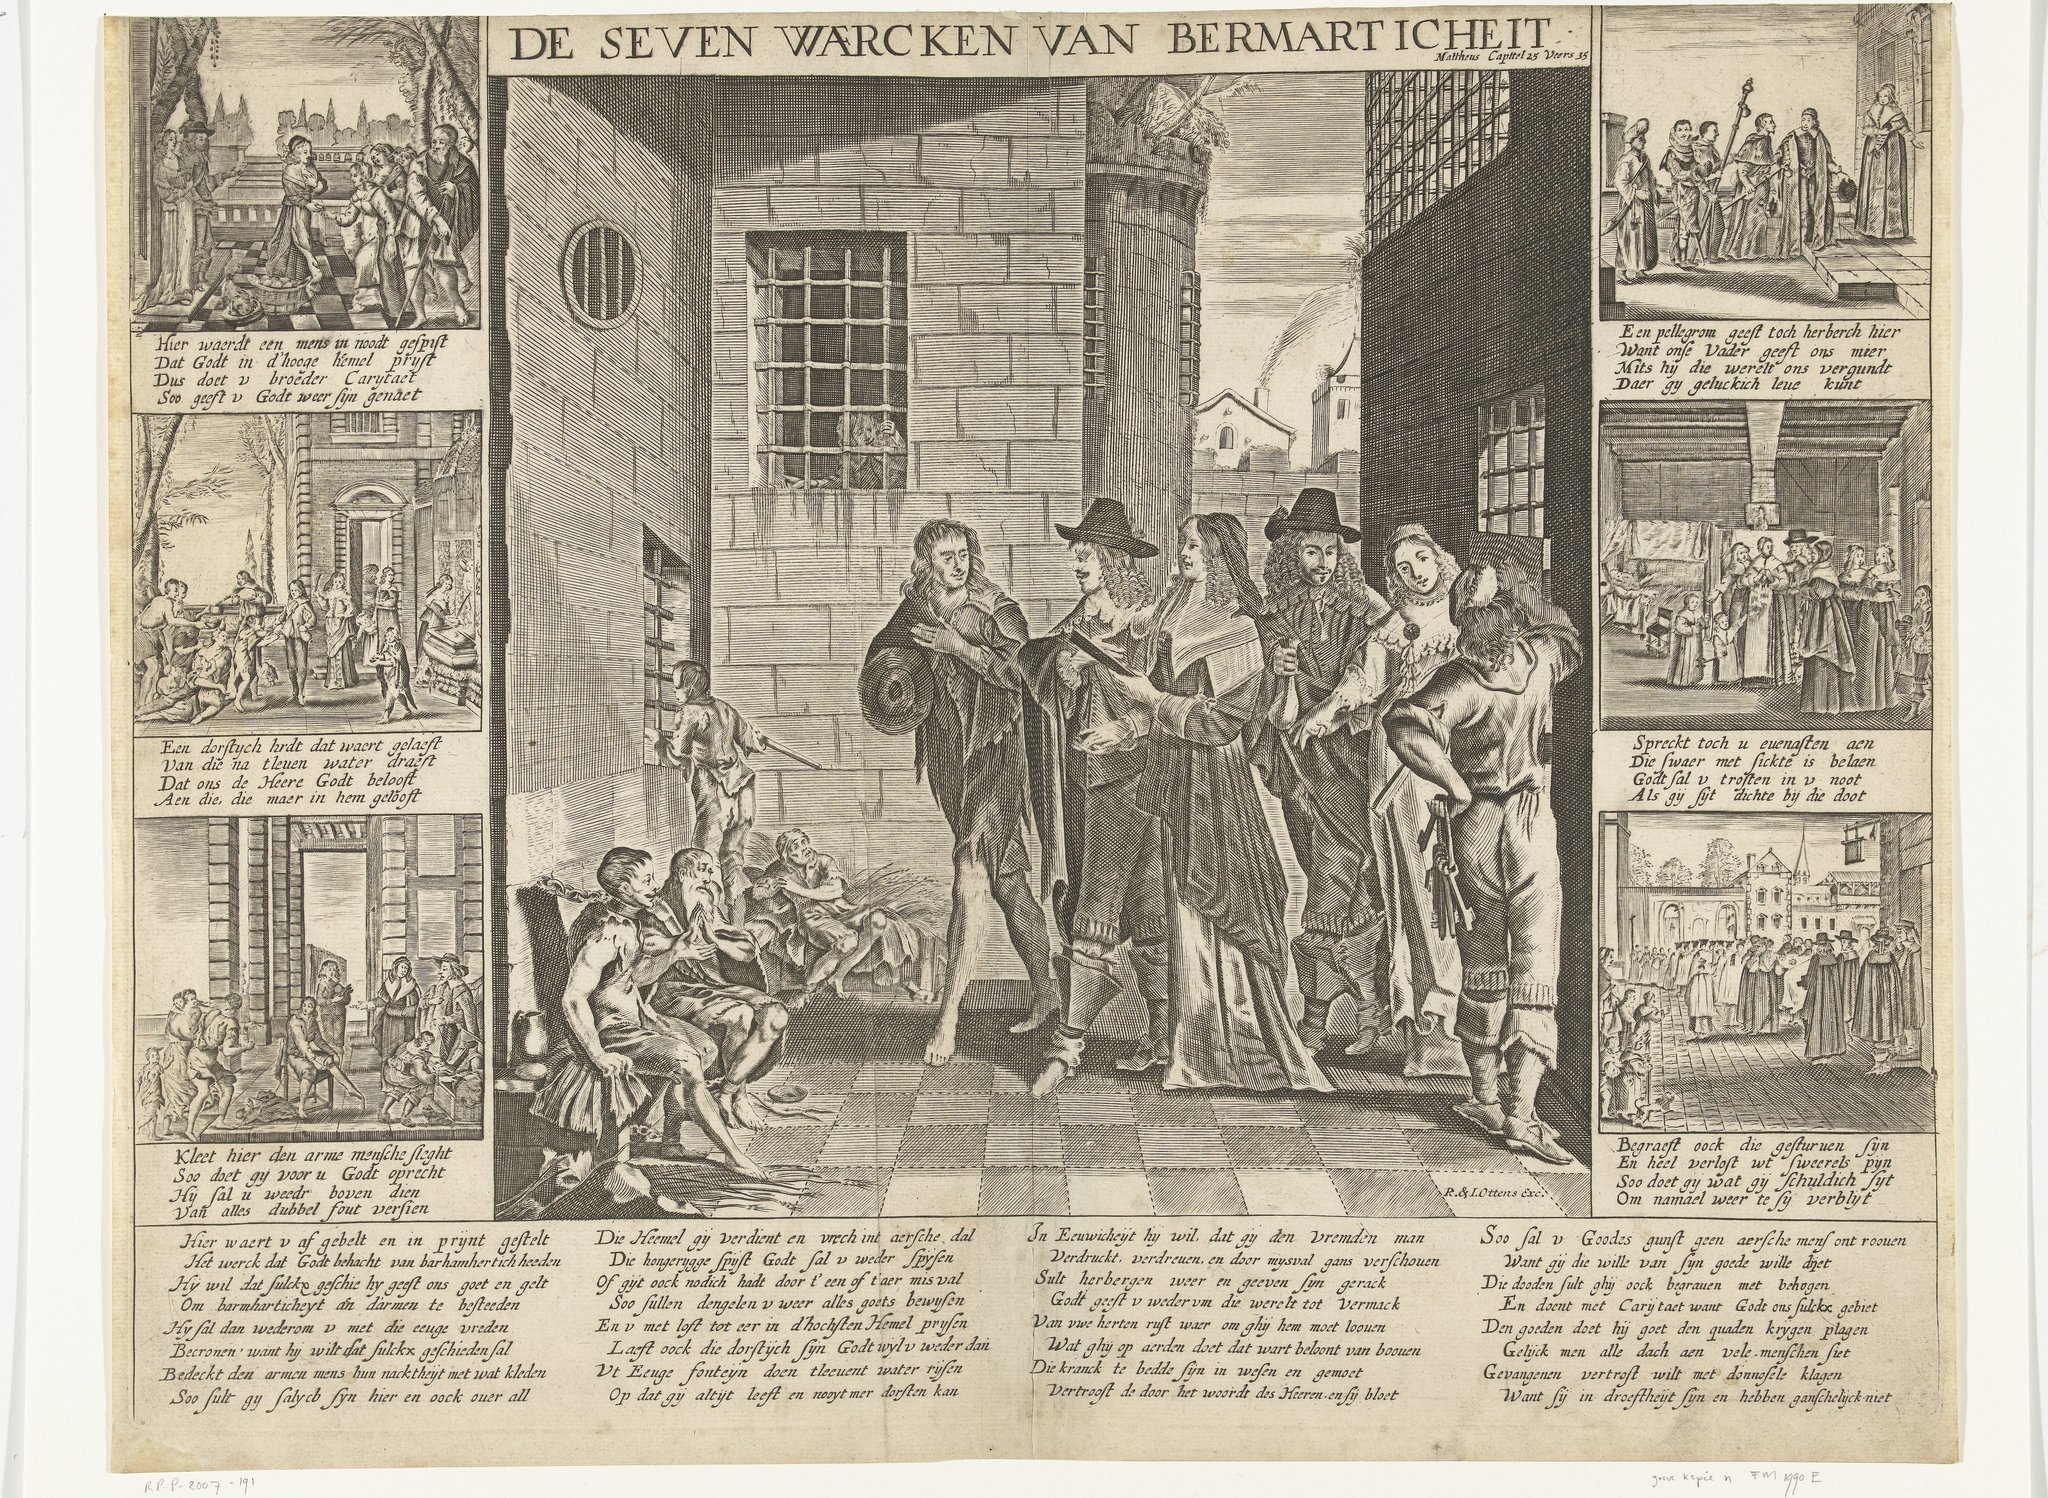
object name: print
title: Royaalbijbel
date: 1725-1751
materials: paper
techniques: engraving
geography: amsterdam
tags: visiting or liberating the imprisoned, 'incarceratus solatur' ~ one of the (seven) acts of mercy, the (seven) acts of mercy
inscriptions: collector's mark: Lugt 2760, collector's mark: Lugt 2228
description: De zeven werken van barmhartigheid. Twee rijke echtparen bezoeken de gevangenen in de gevangenis. Links van boven naar onder drie kleinere voorstellingen met het geven van brood aan de hongerigen, het laven van de dorstigen en het kleden van de naakten. Rechts drie kleinere voorstellingen met het ontvangen van vreemdelingen, het zorgen voor de zieken en het begraven van de doden. Onder de voorstelling vier achtregelige verzen in het Nederlands.